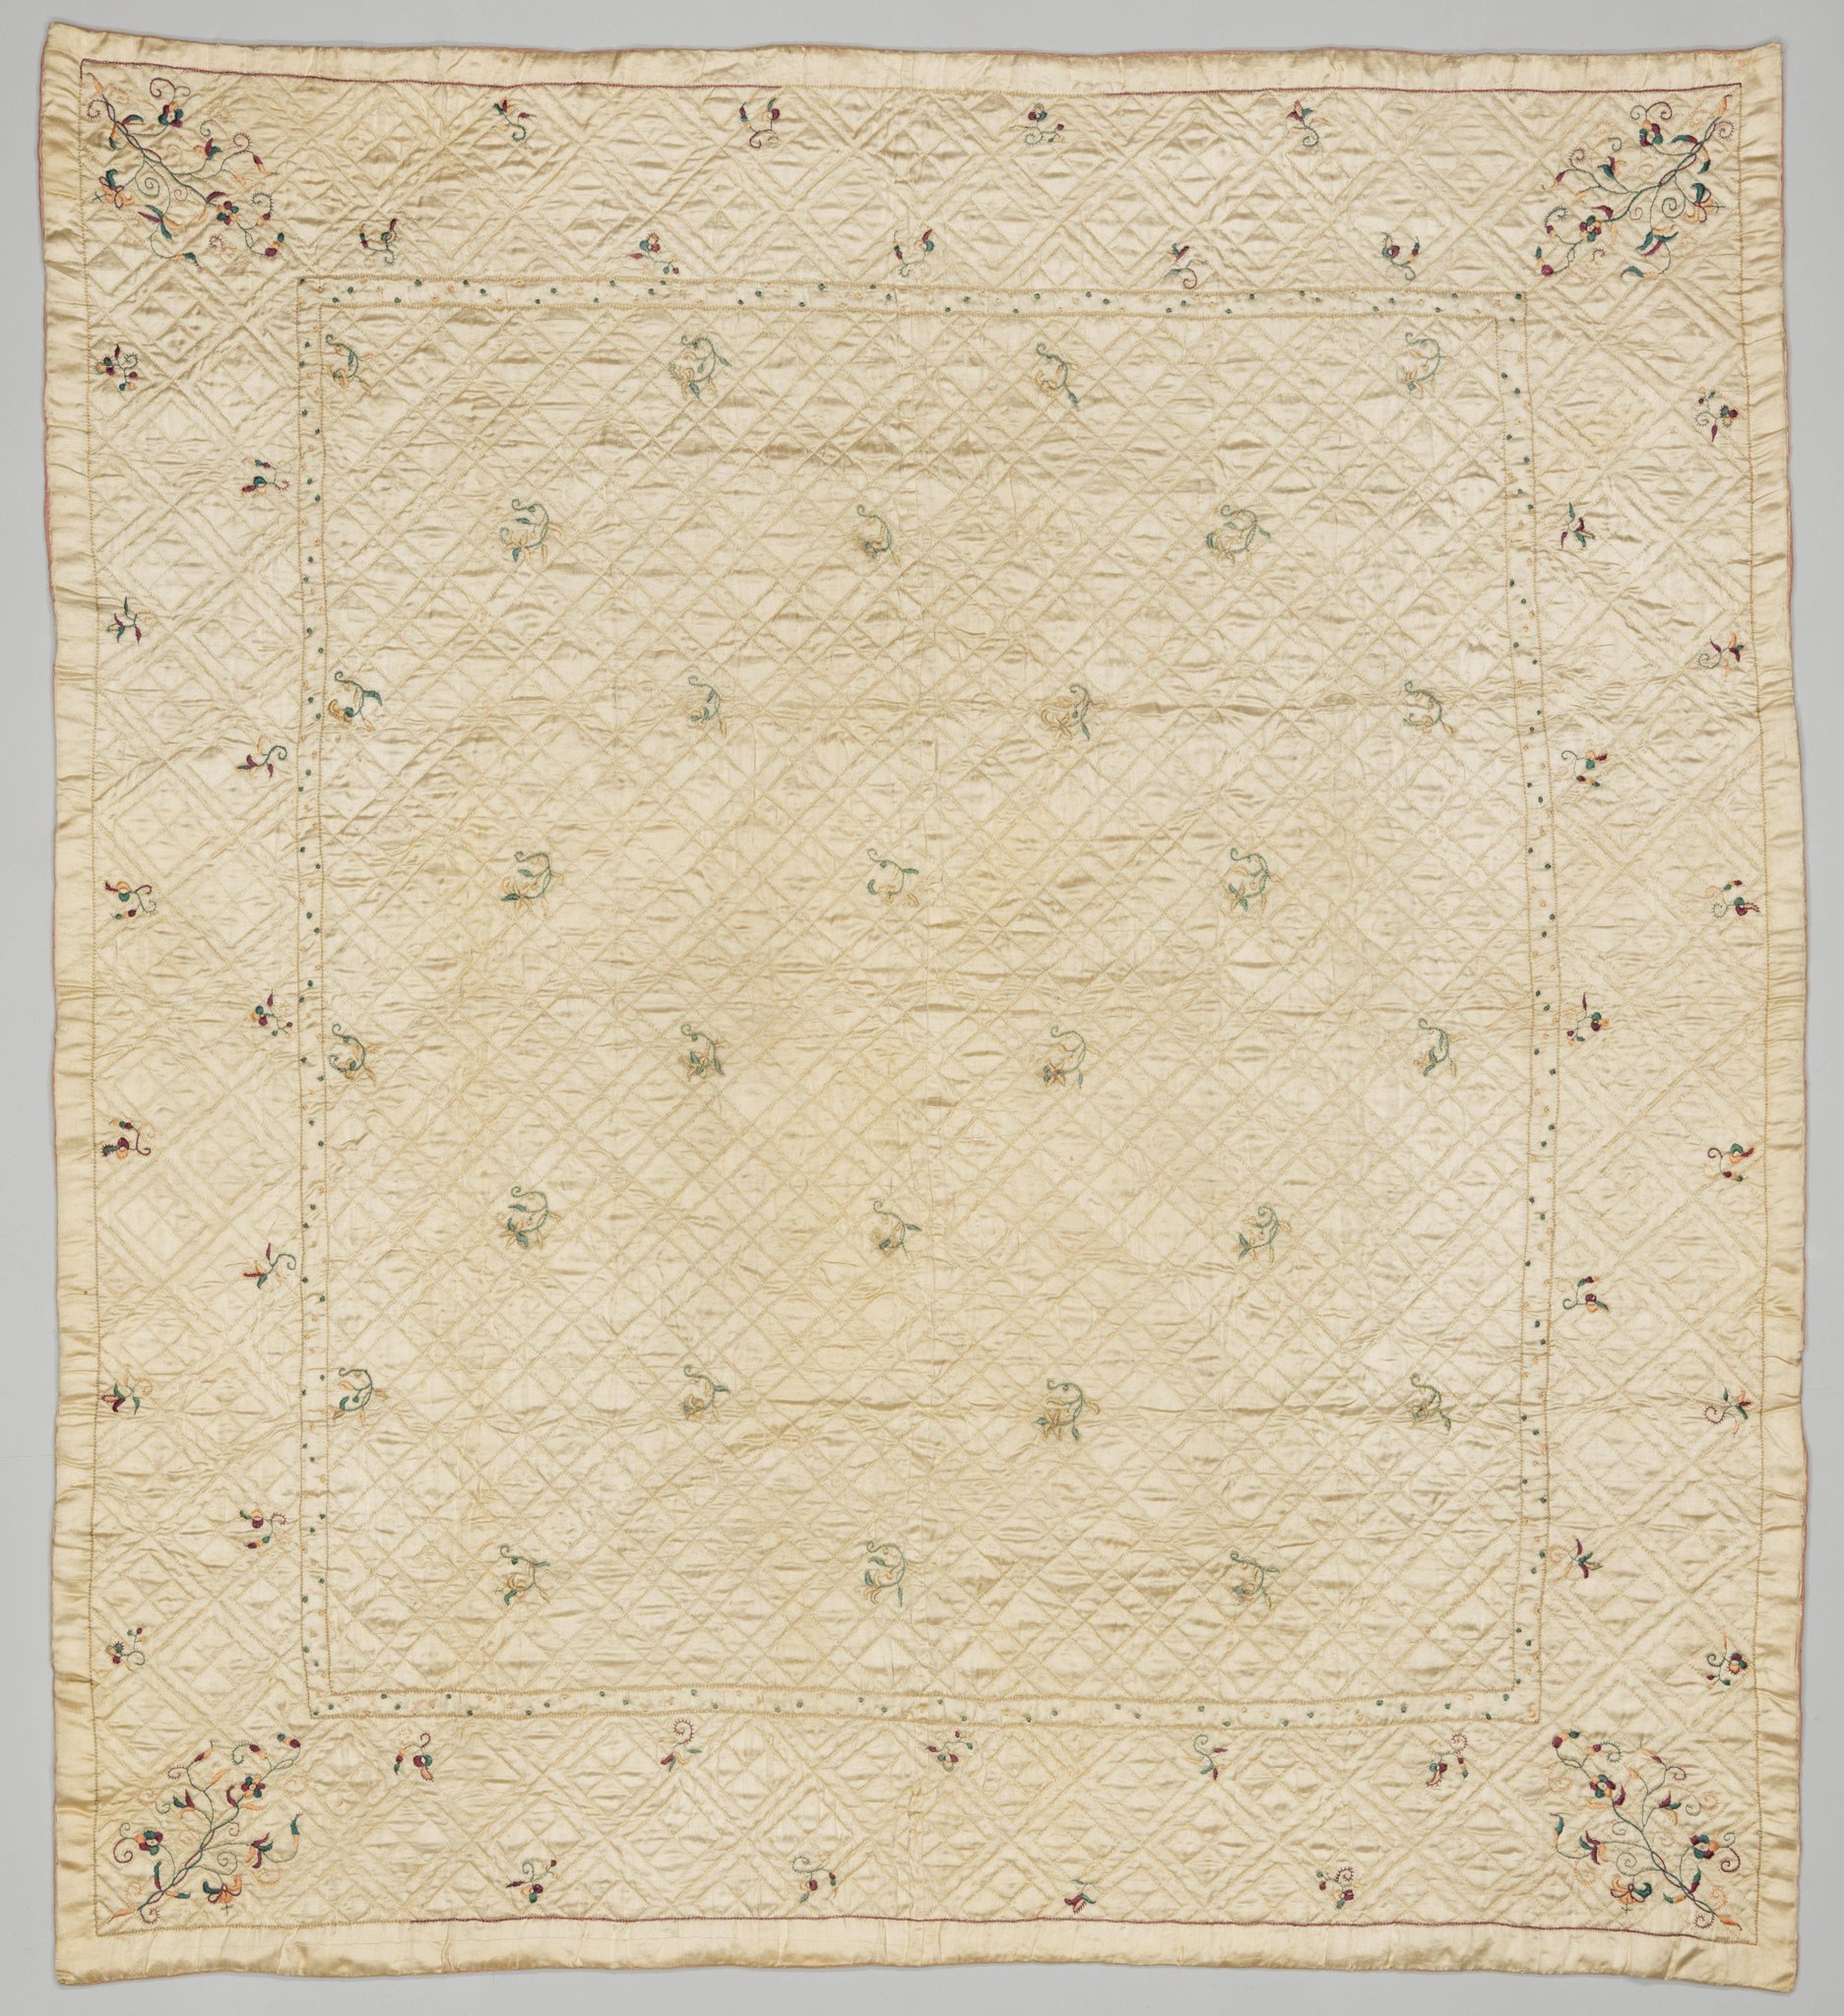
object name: bedspread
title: Een babysprei van witte, gestikte satijn met enkele bloempjes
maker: Anonymous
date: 1700-1799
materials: textile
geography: europe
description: Een babysprei van witte, gestikte satijn met enkele bloempjes.